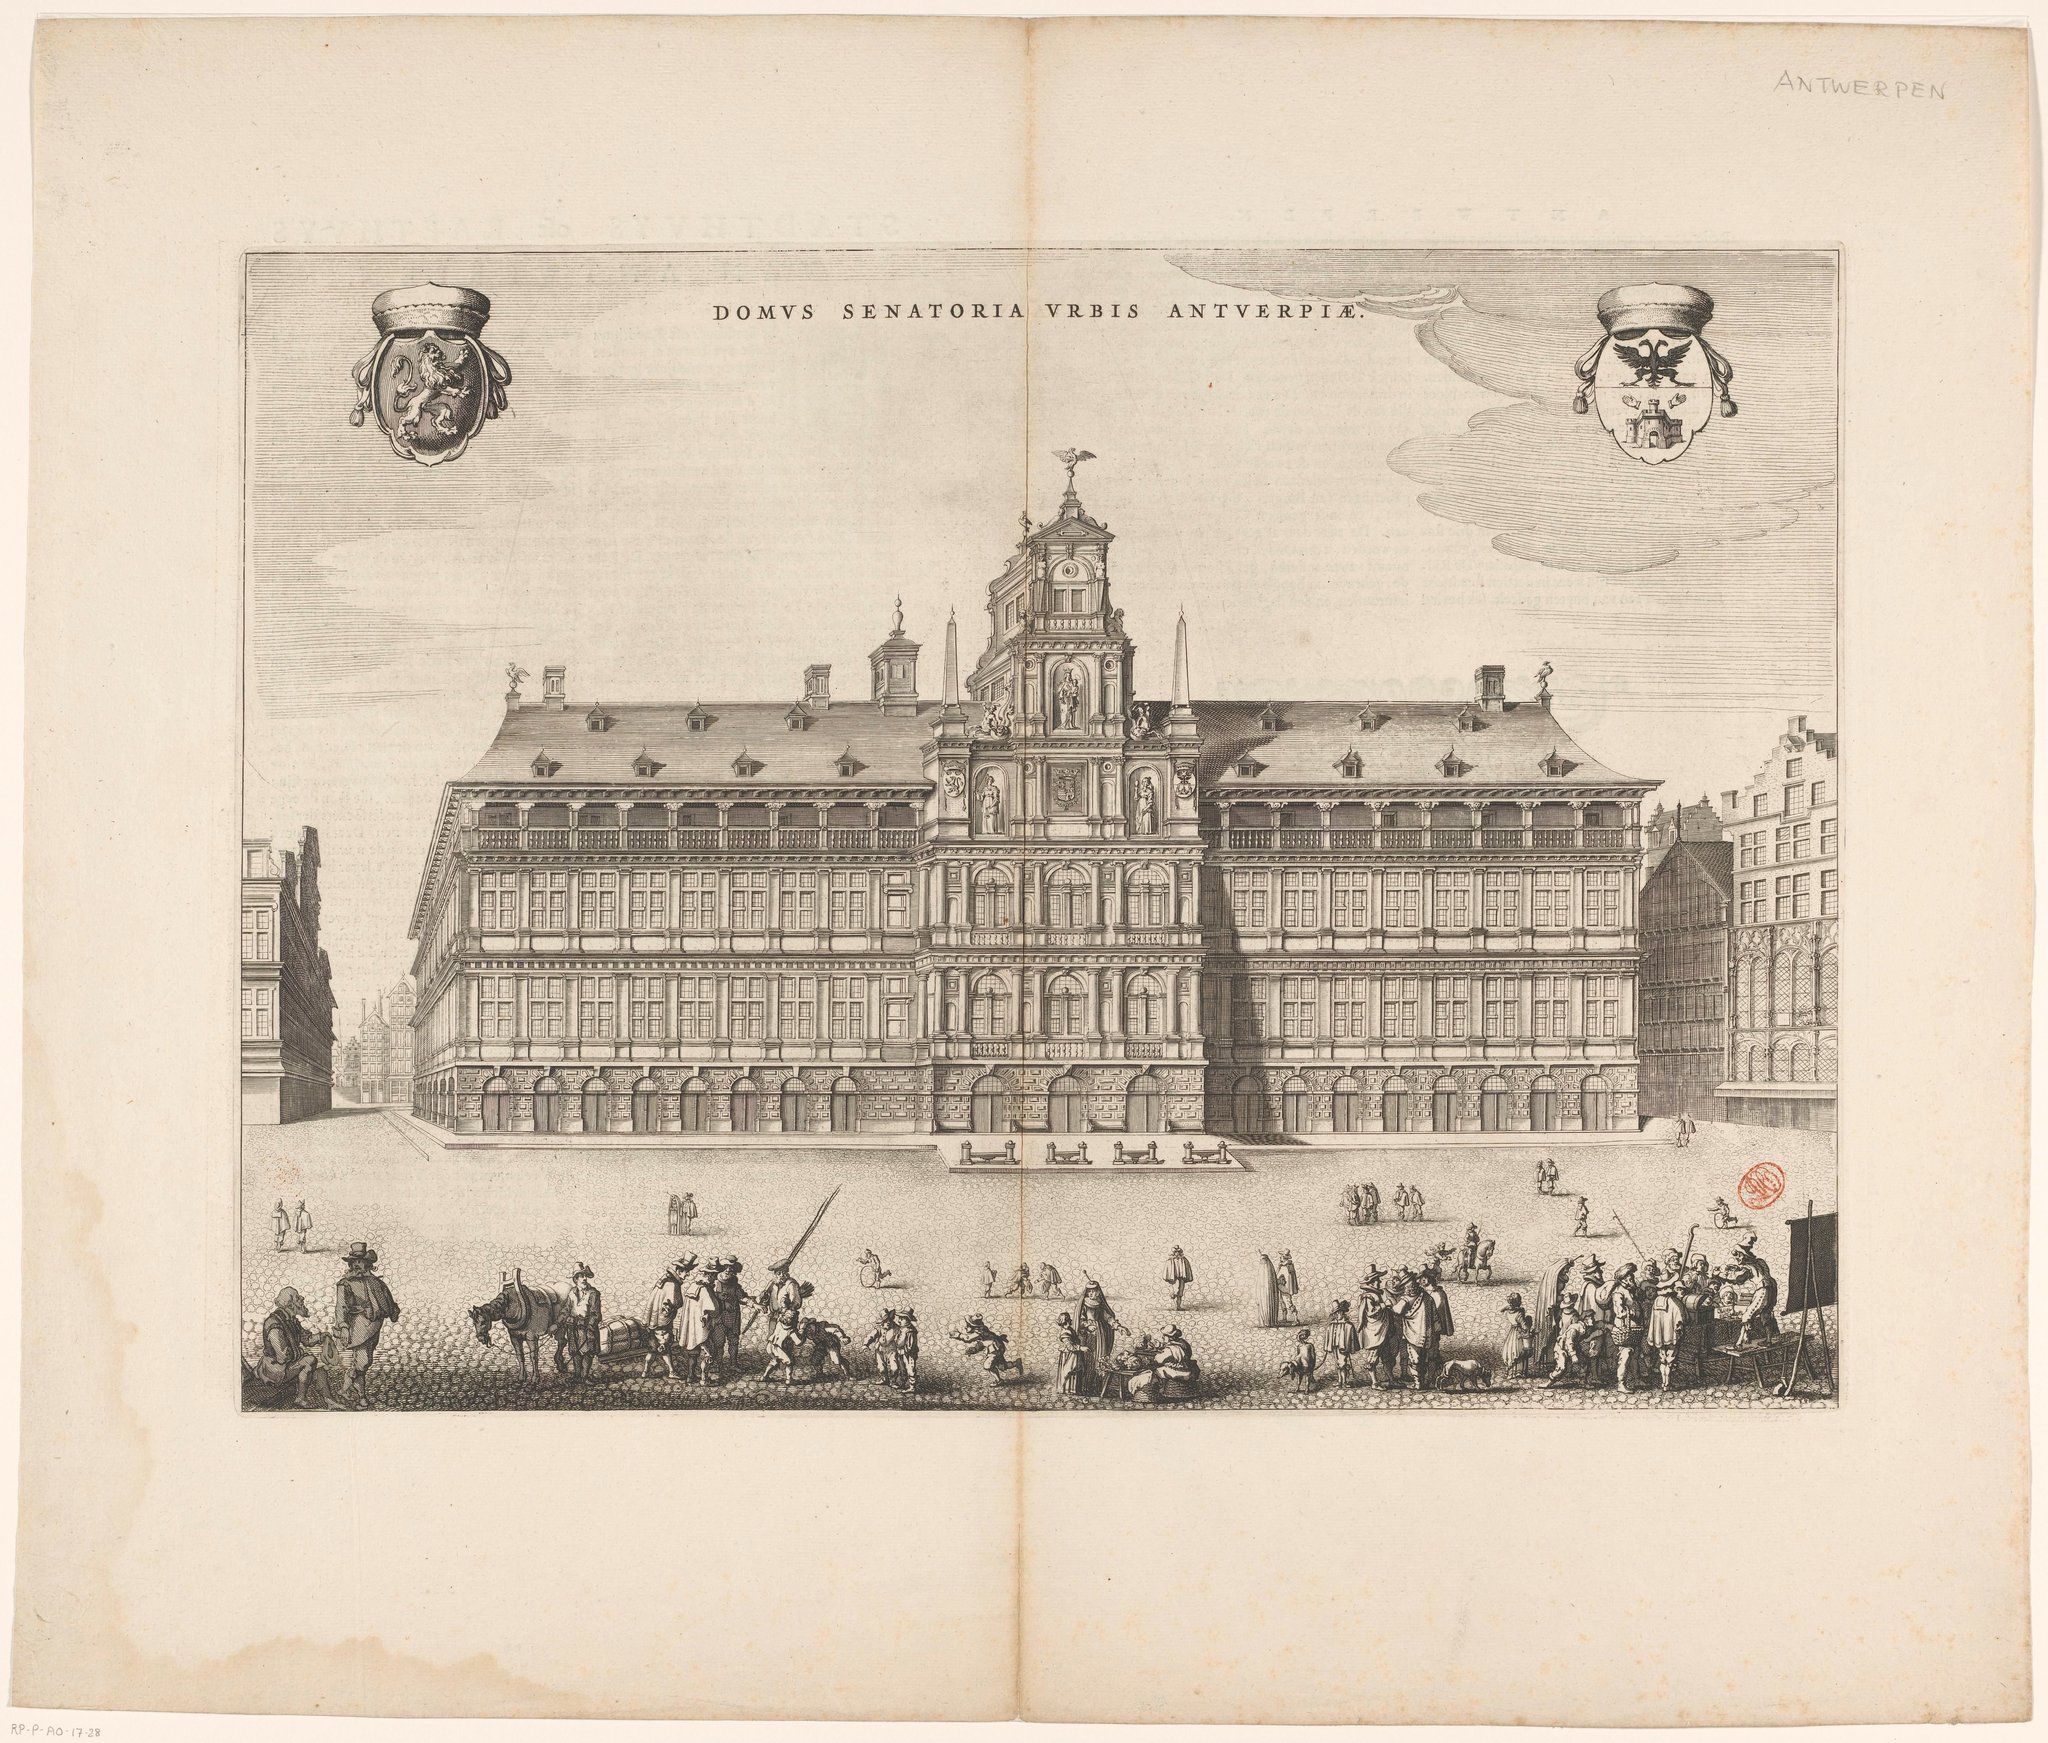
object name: print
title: Gezicht op het Stadhuis van Antwerpen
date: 1652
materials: paper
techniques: engraving, etching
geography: amsterdam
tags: coat of arms (as symbol of the state, etc.) (+ city; municipal), townhall, coat of arms (as symbol of the state, etc.) (+ province; provincial)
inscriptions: collector's mark: Lugt 195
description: Gezicht op het Stadhuis van Antwerpen met op de voorgrond verschillende figuren. Linksboven het gespiegelde wapen van Brabant en rechtsboven het wapen van Antwerpen. Op verso Nederlandse tekst.